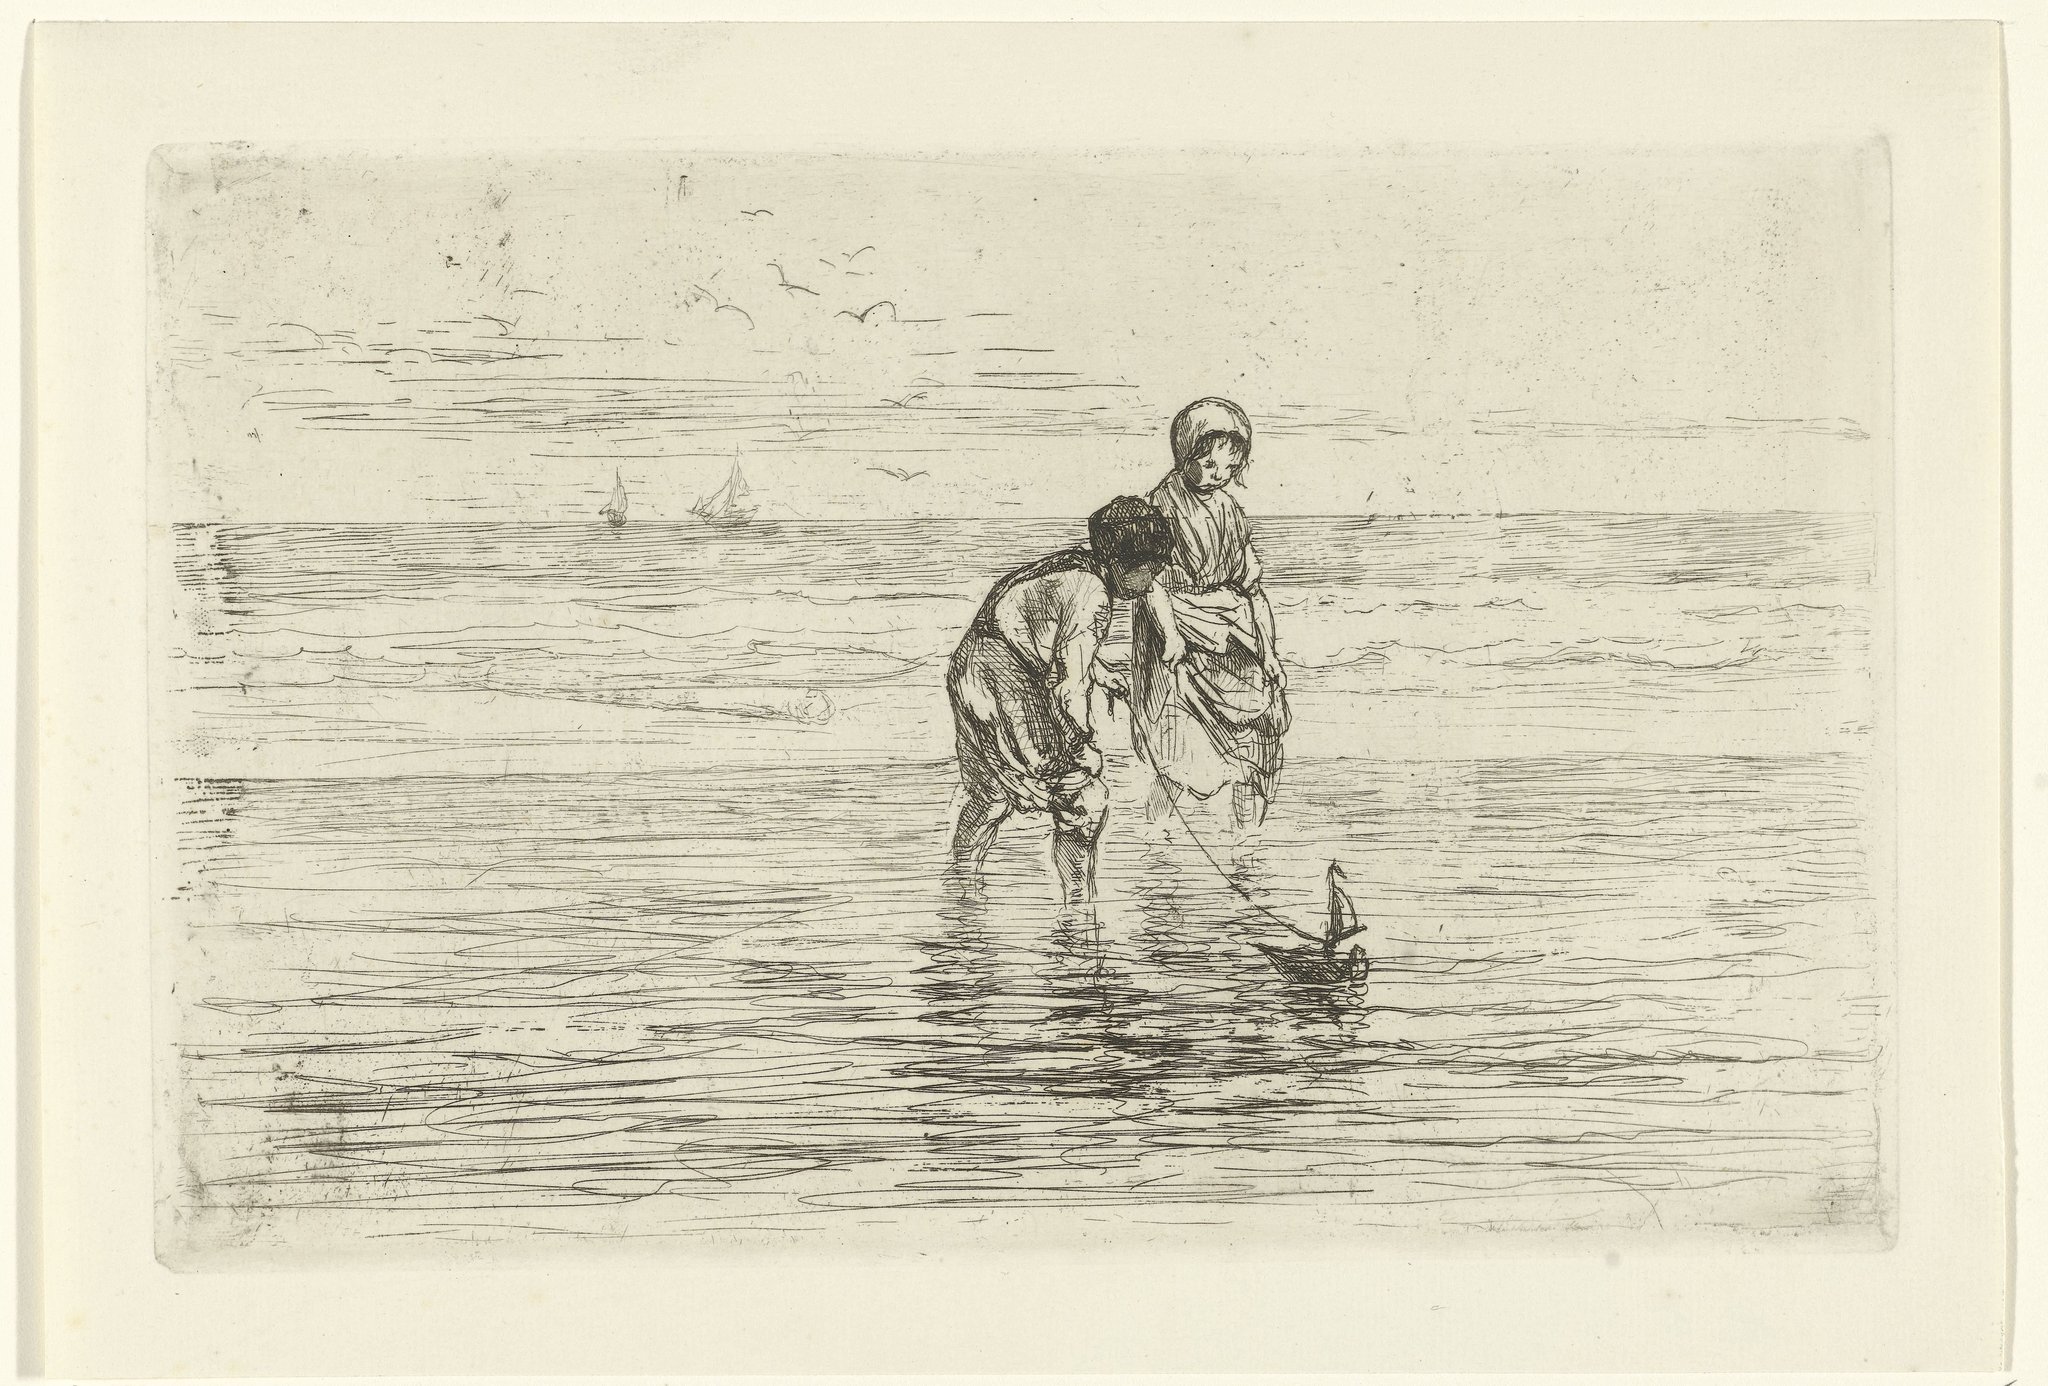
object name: print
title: Kinderen spelend met een scheepje aan het strand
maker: jozef israëls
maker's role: draughtsman, painter, print maker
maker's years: 1824-1911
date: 1835-1910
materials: paper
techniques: etching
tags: (playing with) toys, in or beside the water (on the beach)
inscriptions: collector's mark: Lugt 2228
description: Twee kinderen, een meisje en een jongen, staan tot hun kuiten in het water en spelen met een scheepje. Aan de horizon twee zeilschepen.